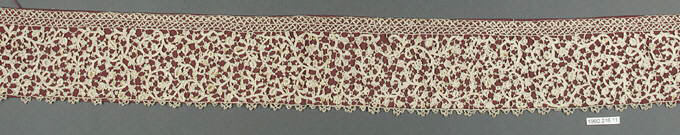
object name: edging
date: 1601-1700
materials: linen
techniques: lace